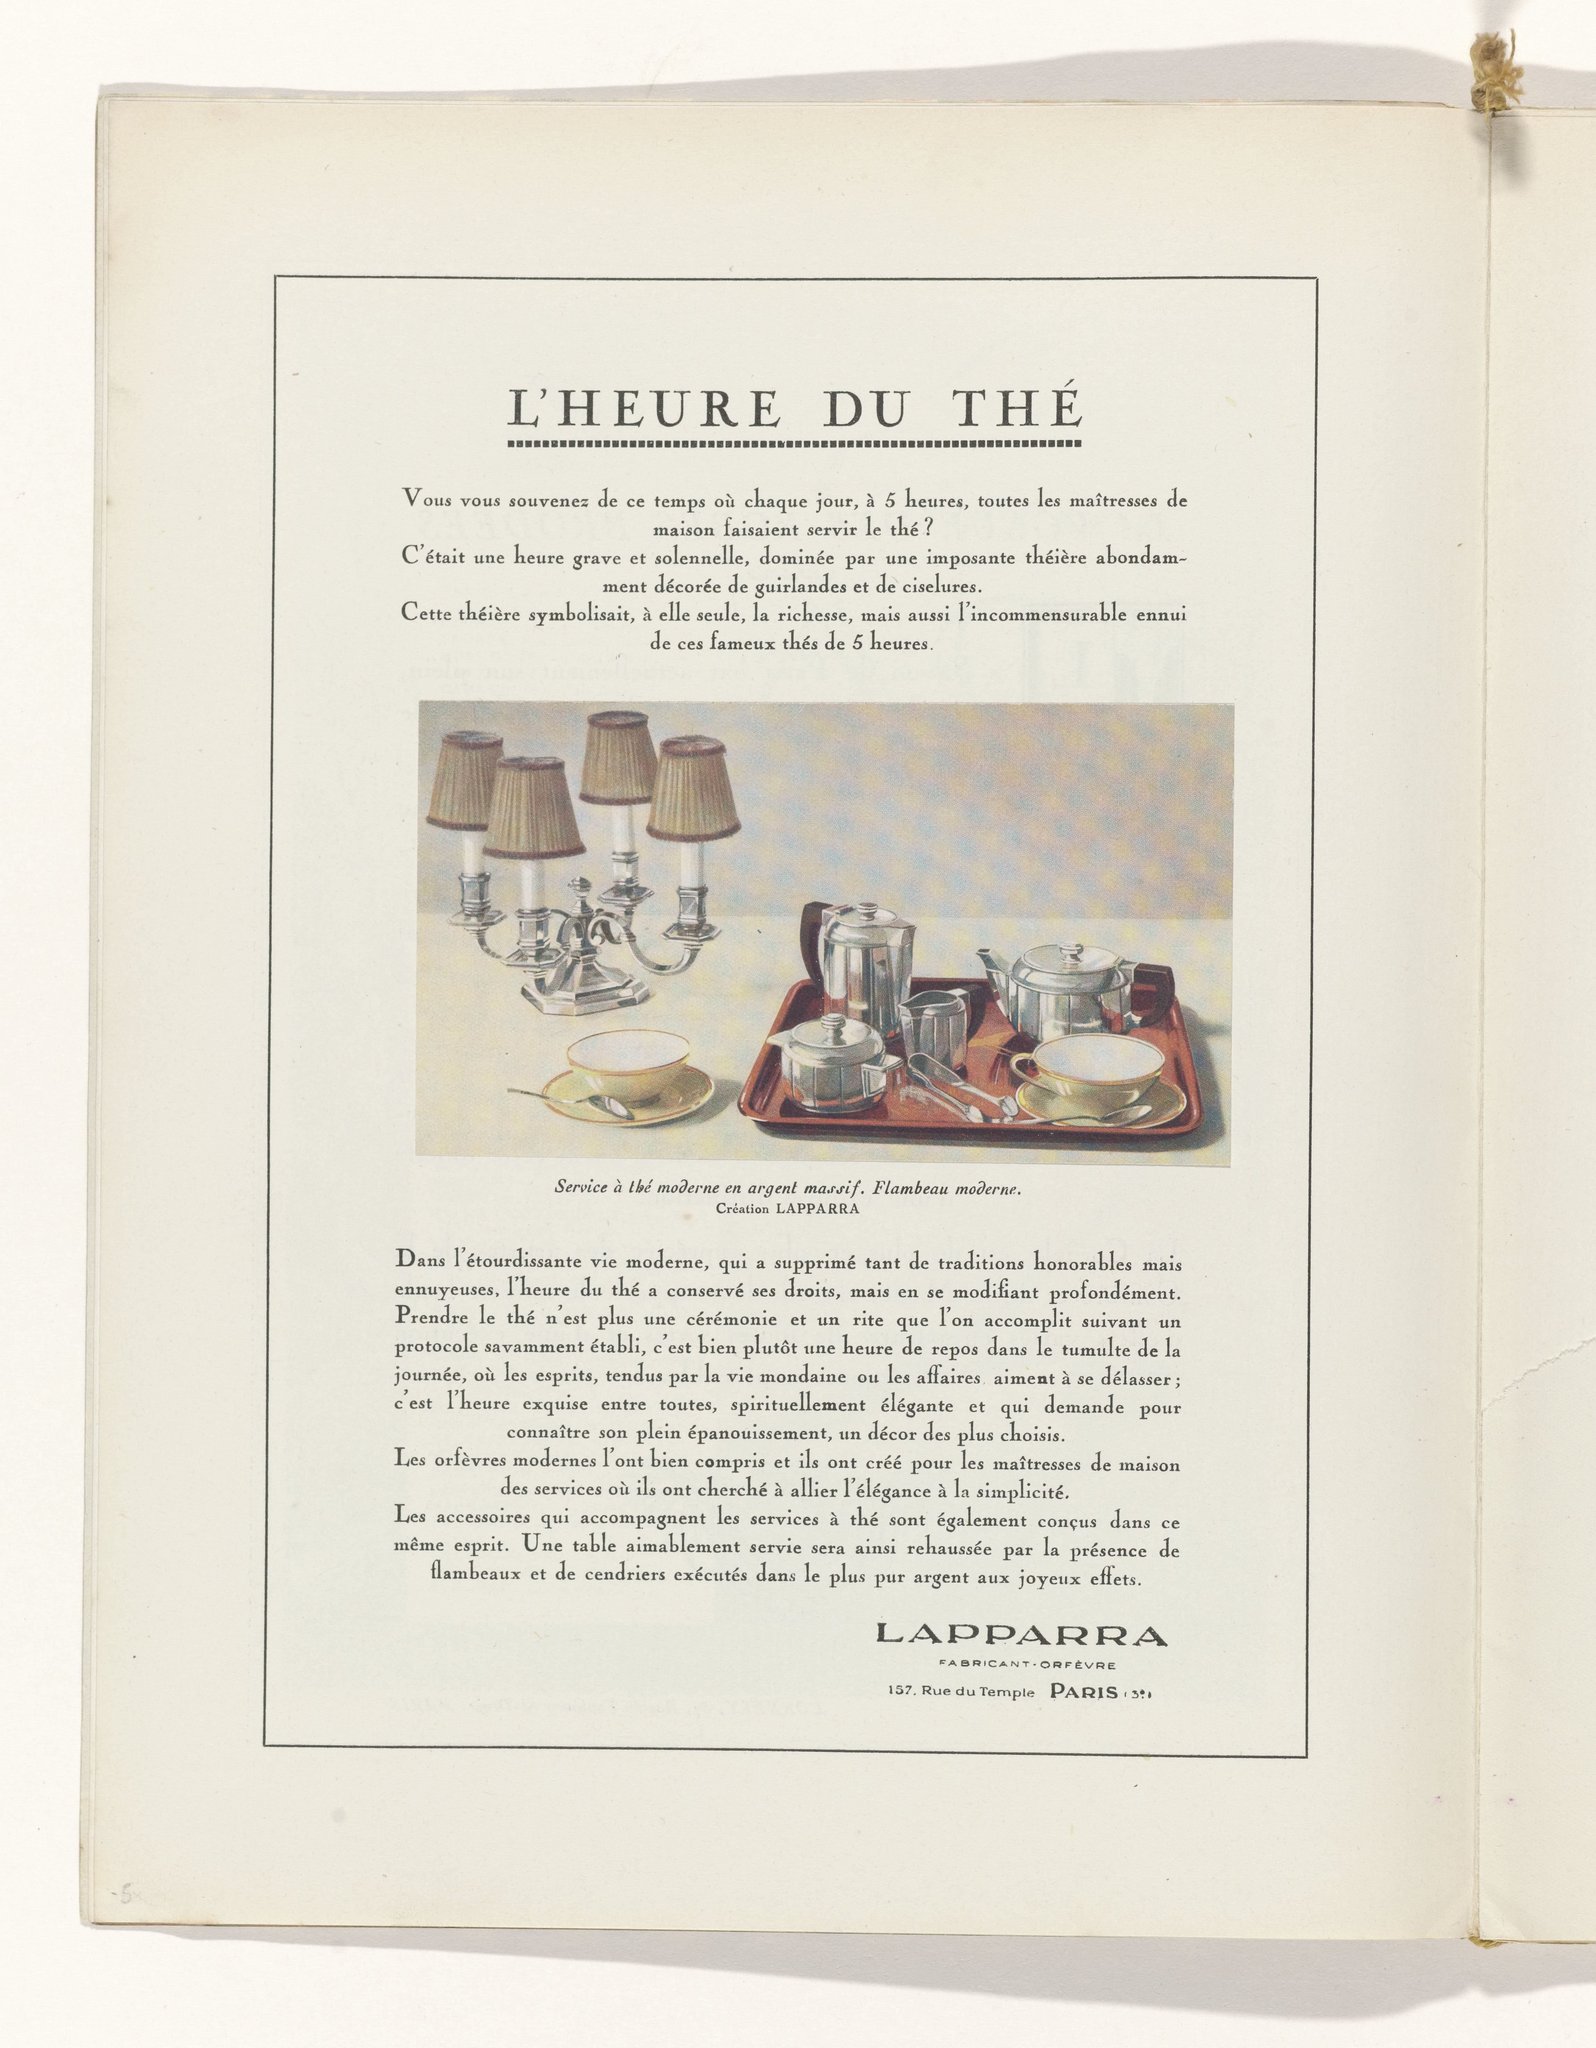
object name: fashion print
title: Art - Goût - Beauté, Feuillets de l' élégance féminine, Juin 1929, No. 106, 9e Année, p.5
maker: charles goy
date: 1929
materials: paper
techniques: printing, lithograph, photography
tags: fashion plates, lighting; lamps, tea- and coffee-service, cup and saucer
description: Tekst 'L'heure du thé' met een afbeelding van een modern theeservies van zilver, van Lapparra. Pagina uit het modetijdschrift Art-Goût-Beauté (1920-1933).